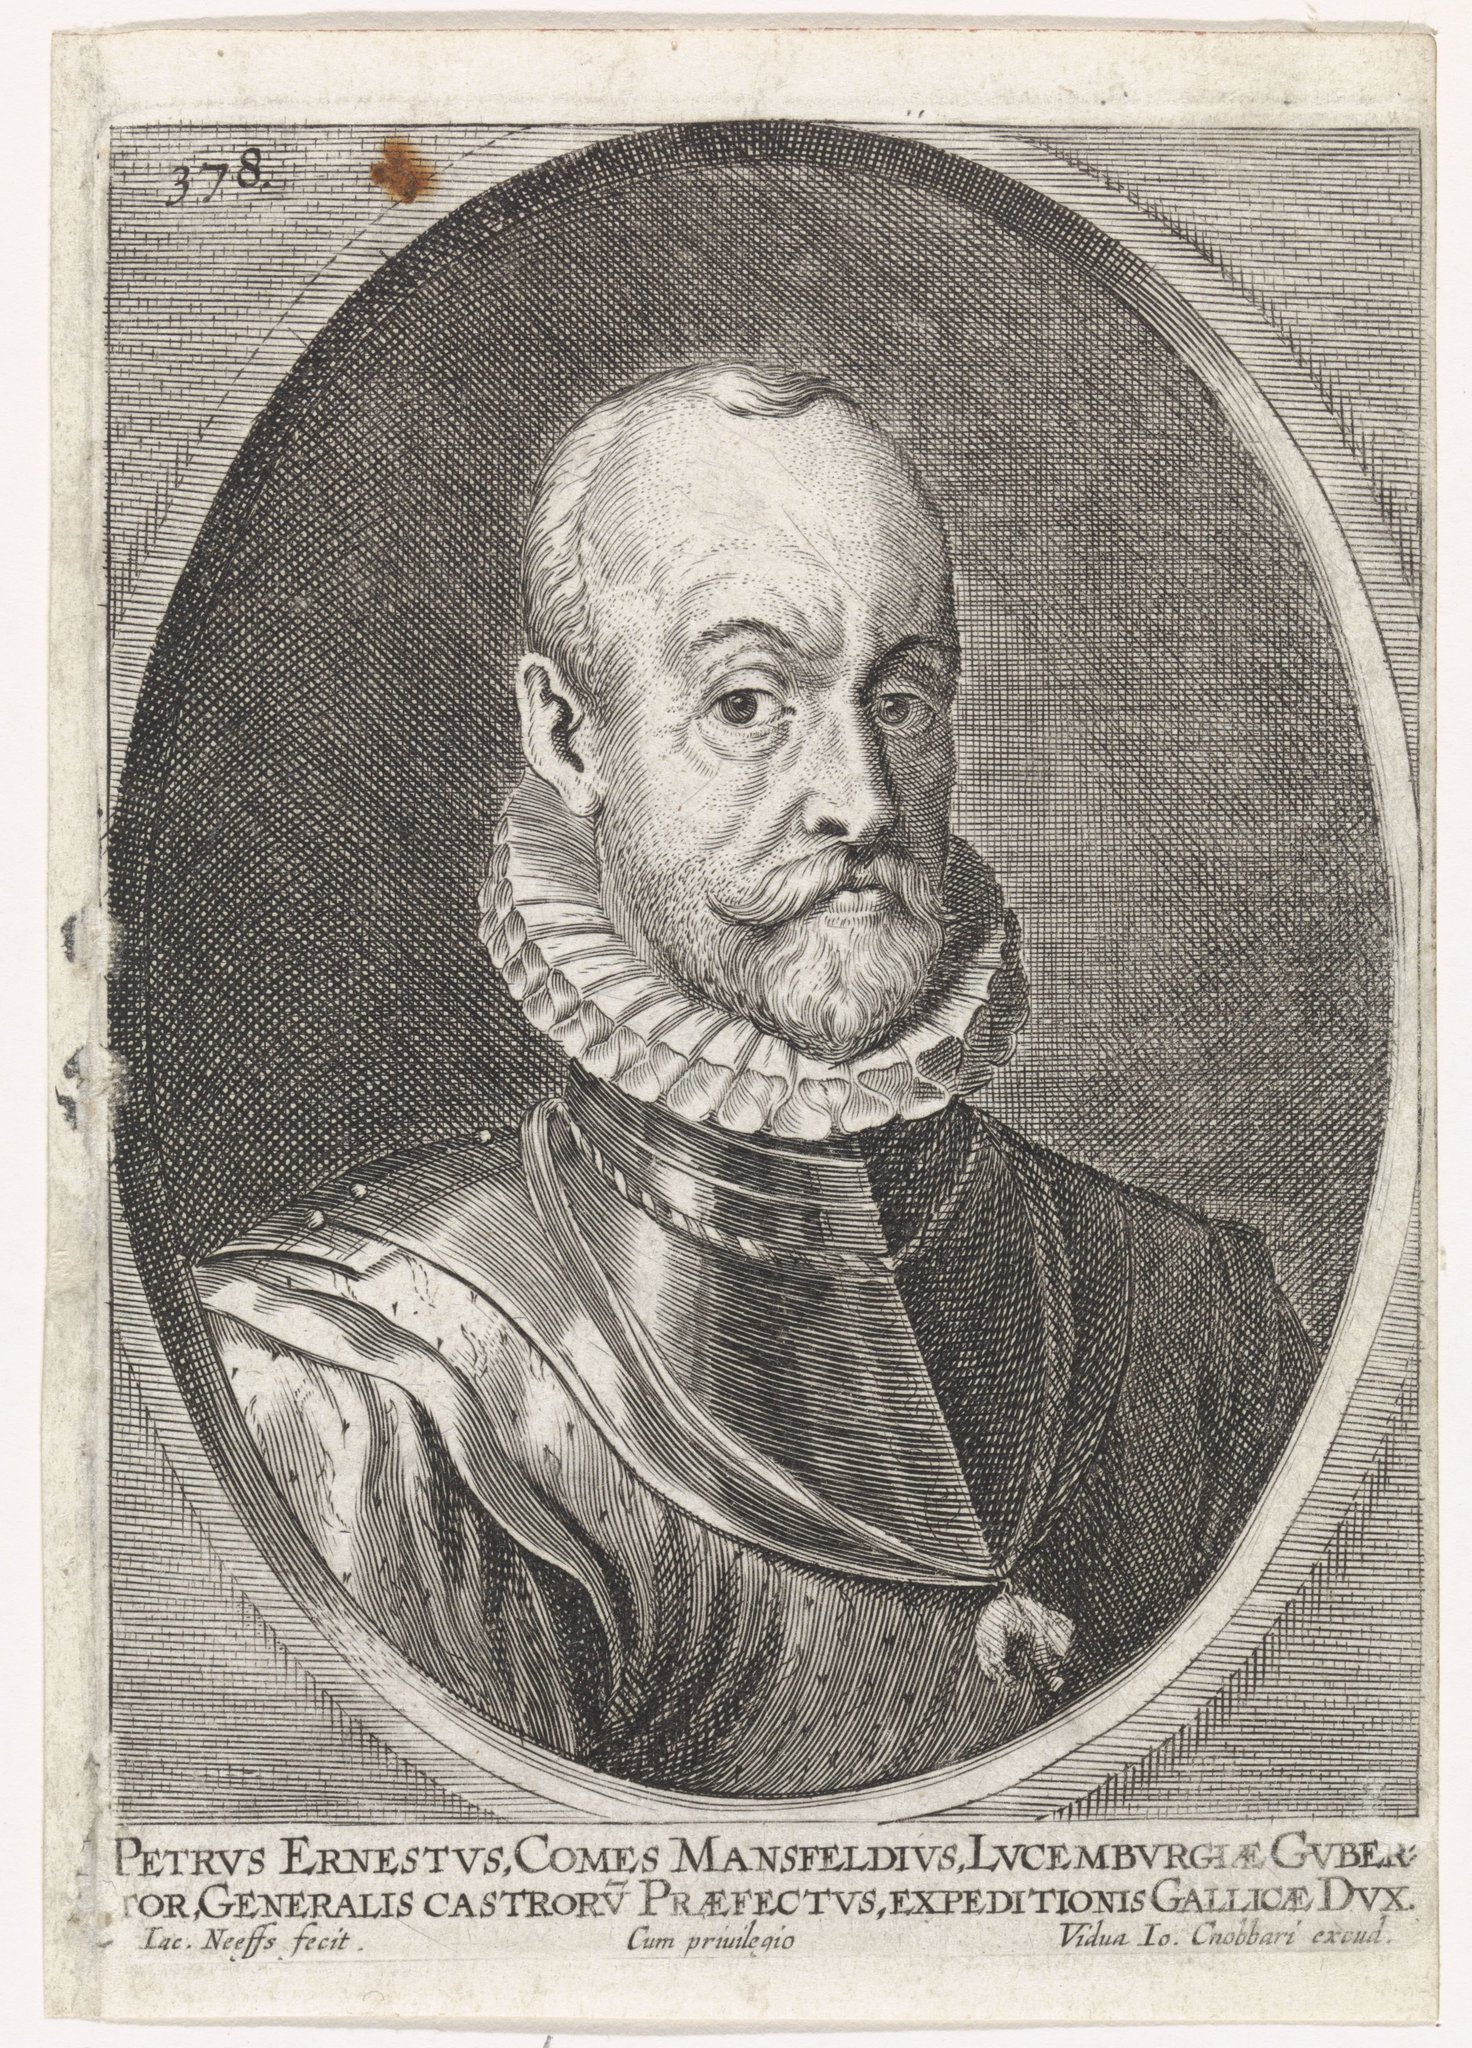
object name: print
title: Portret van Peter Ernst, graaf von Mansveld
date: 1620-1680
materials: paper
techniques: engraving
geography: antwerp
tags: earl, peter ernst von mansfeld (graaf)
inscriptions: collector's mark: Lugt 2228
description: Peter Ernst, graaf von Mansveld, met een plooikraag en een ketting van de Orde van het Gulden Vlies op de borst. Busteportret naar rechts in ovaal. Linksboven genummerd: 378. Onderaan in de marge een tweeregelige tekst in het Latijn.